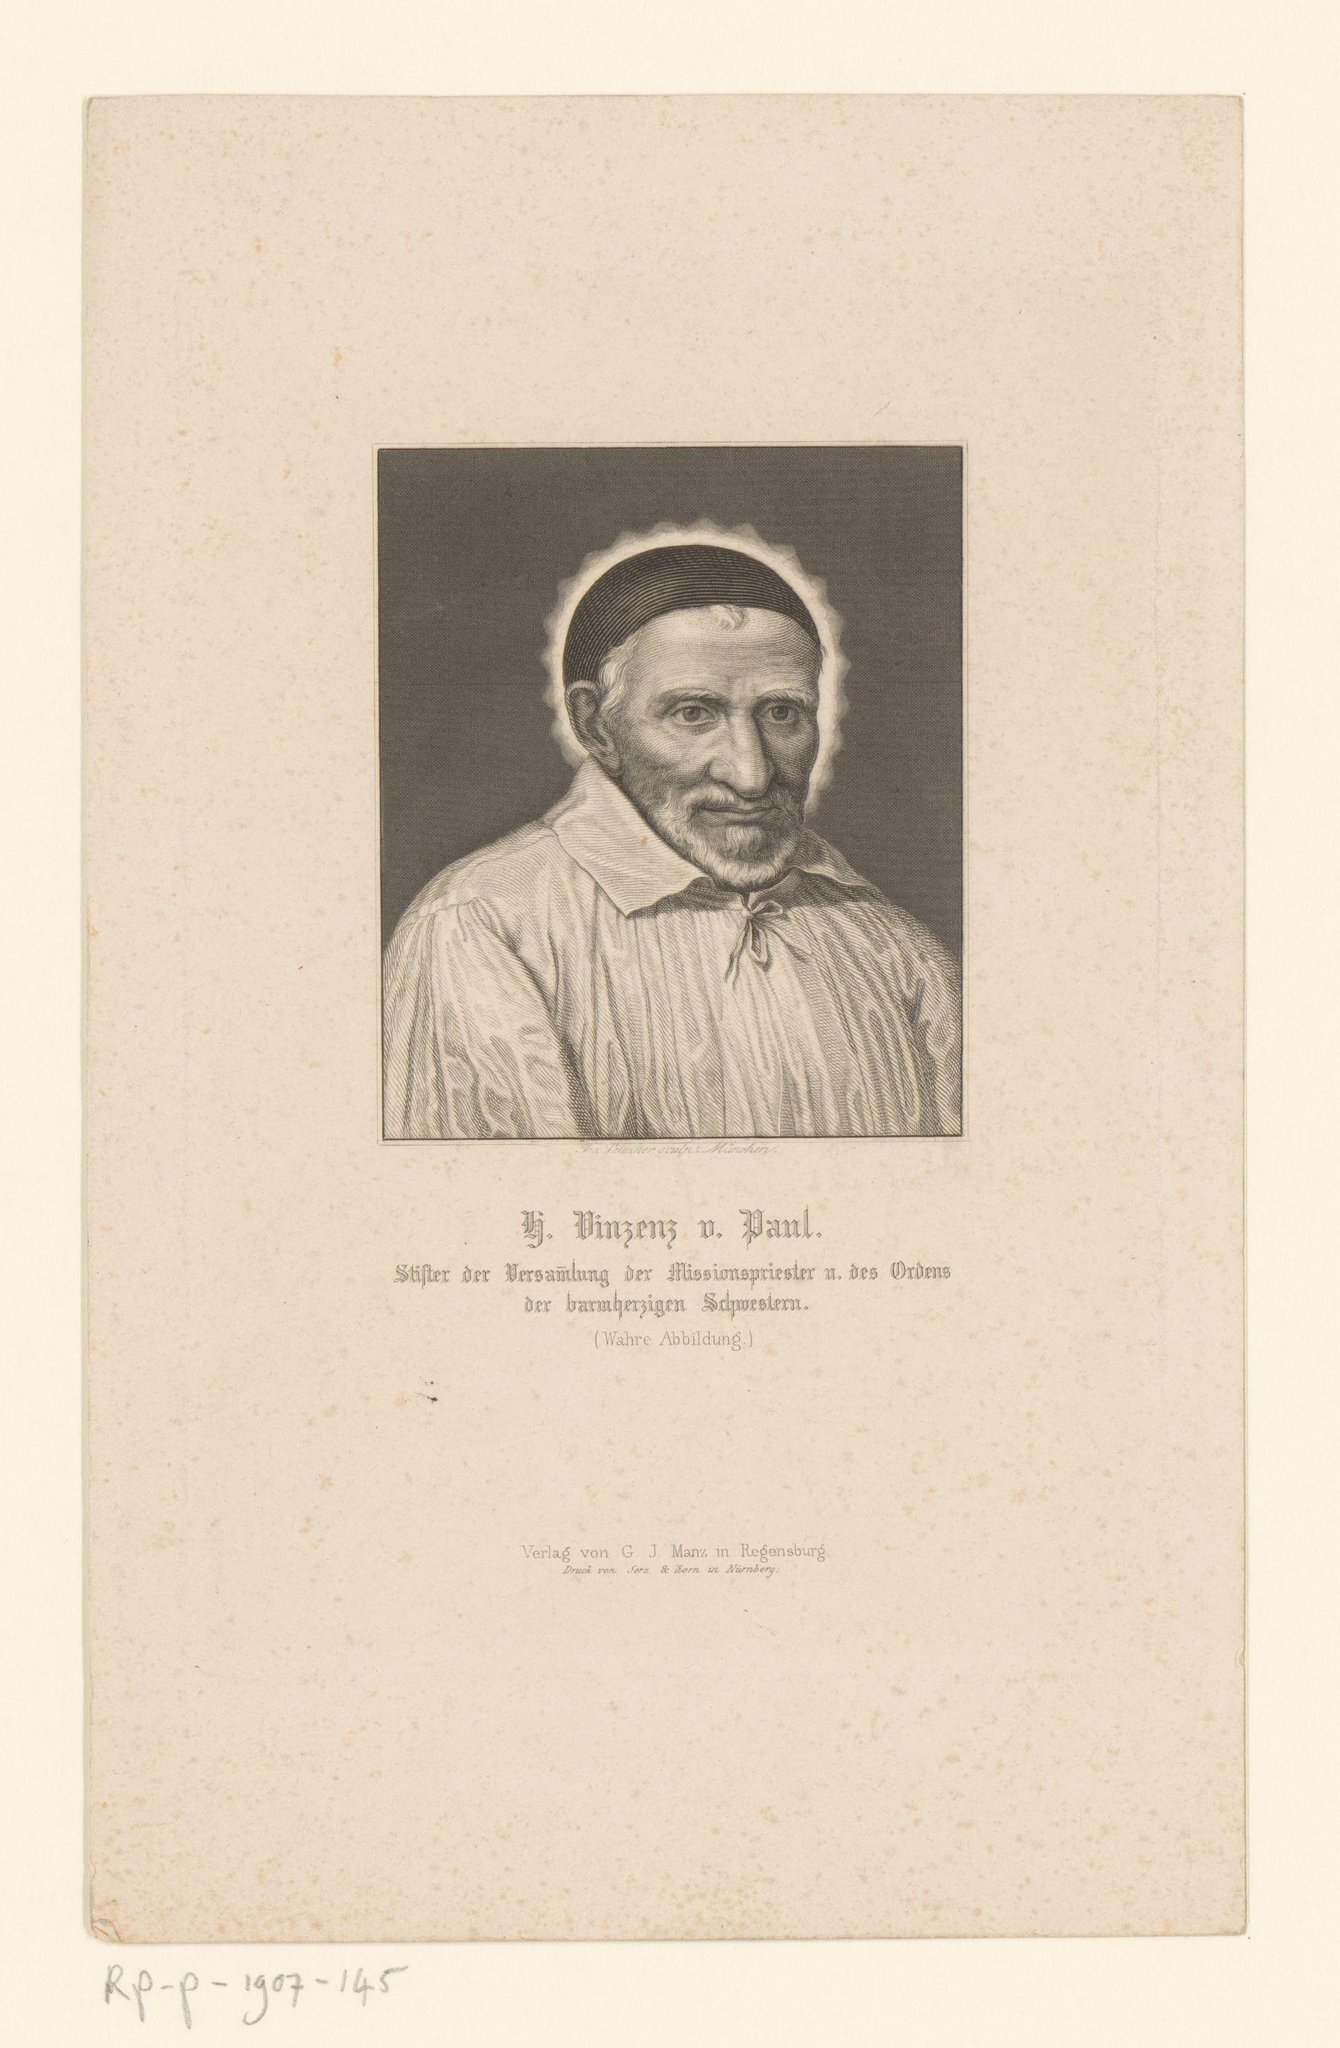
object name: print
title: Portret van Vincent de Paul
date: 1800-1899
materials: paper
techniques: engraving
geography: nuremberg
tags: paris, priest, nimbus, halo ~ radiance emanating from persons or things, historical persons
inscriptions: collector's mark: Lugt 2228